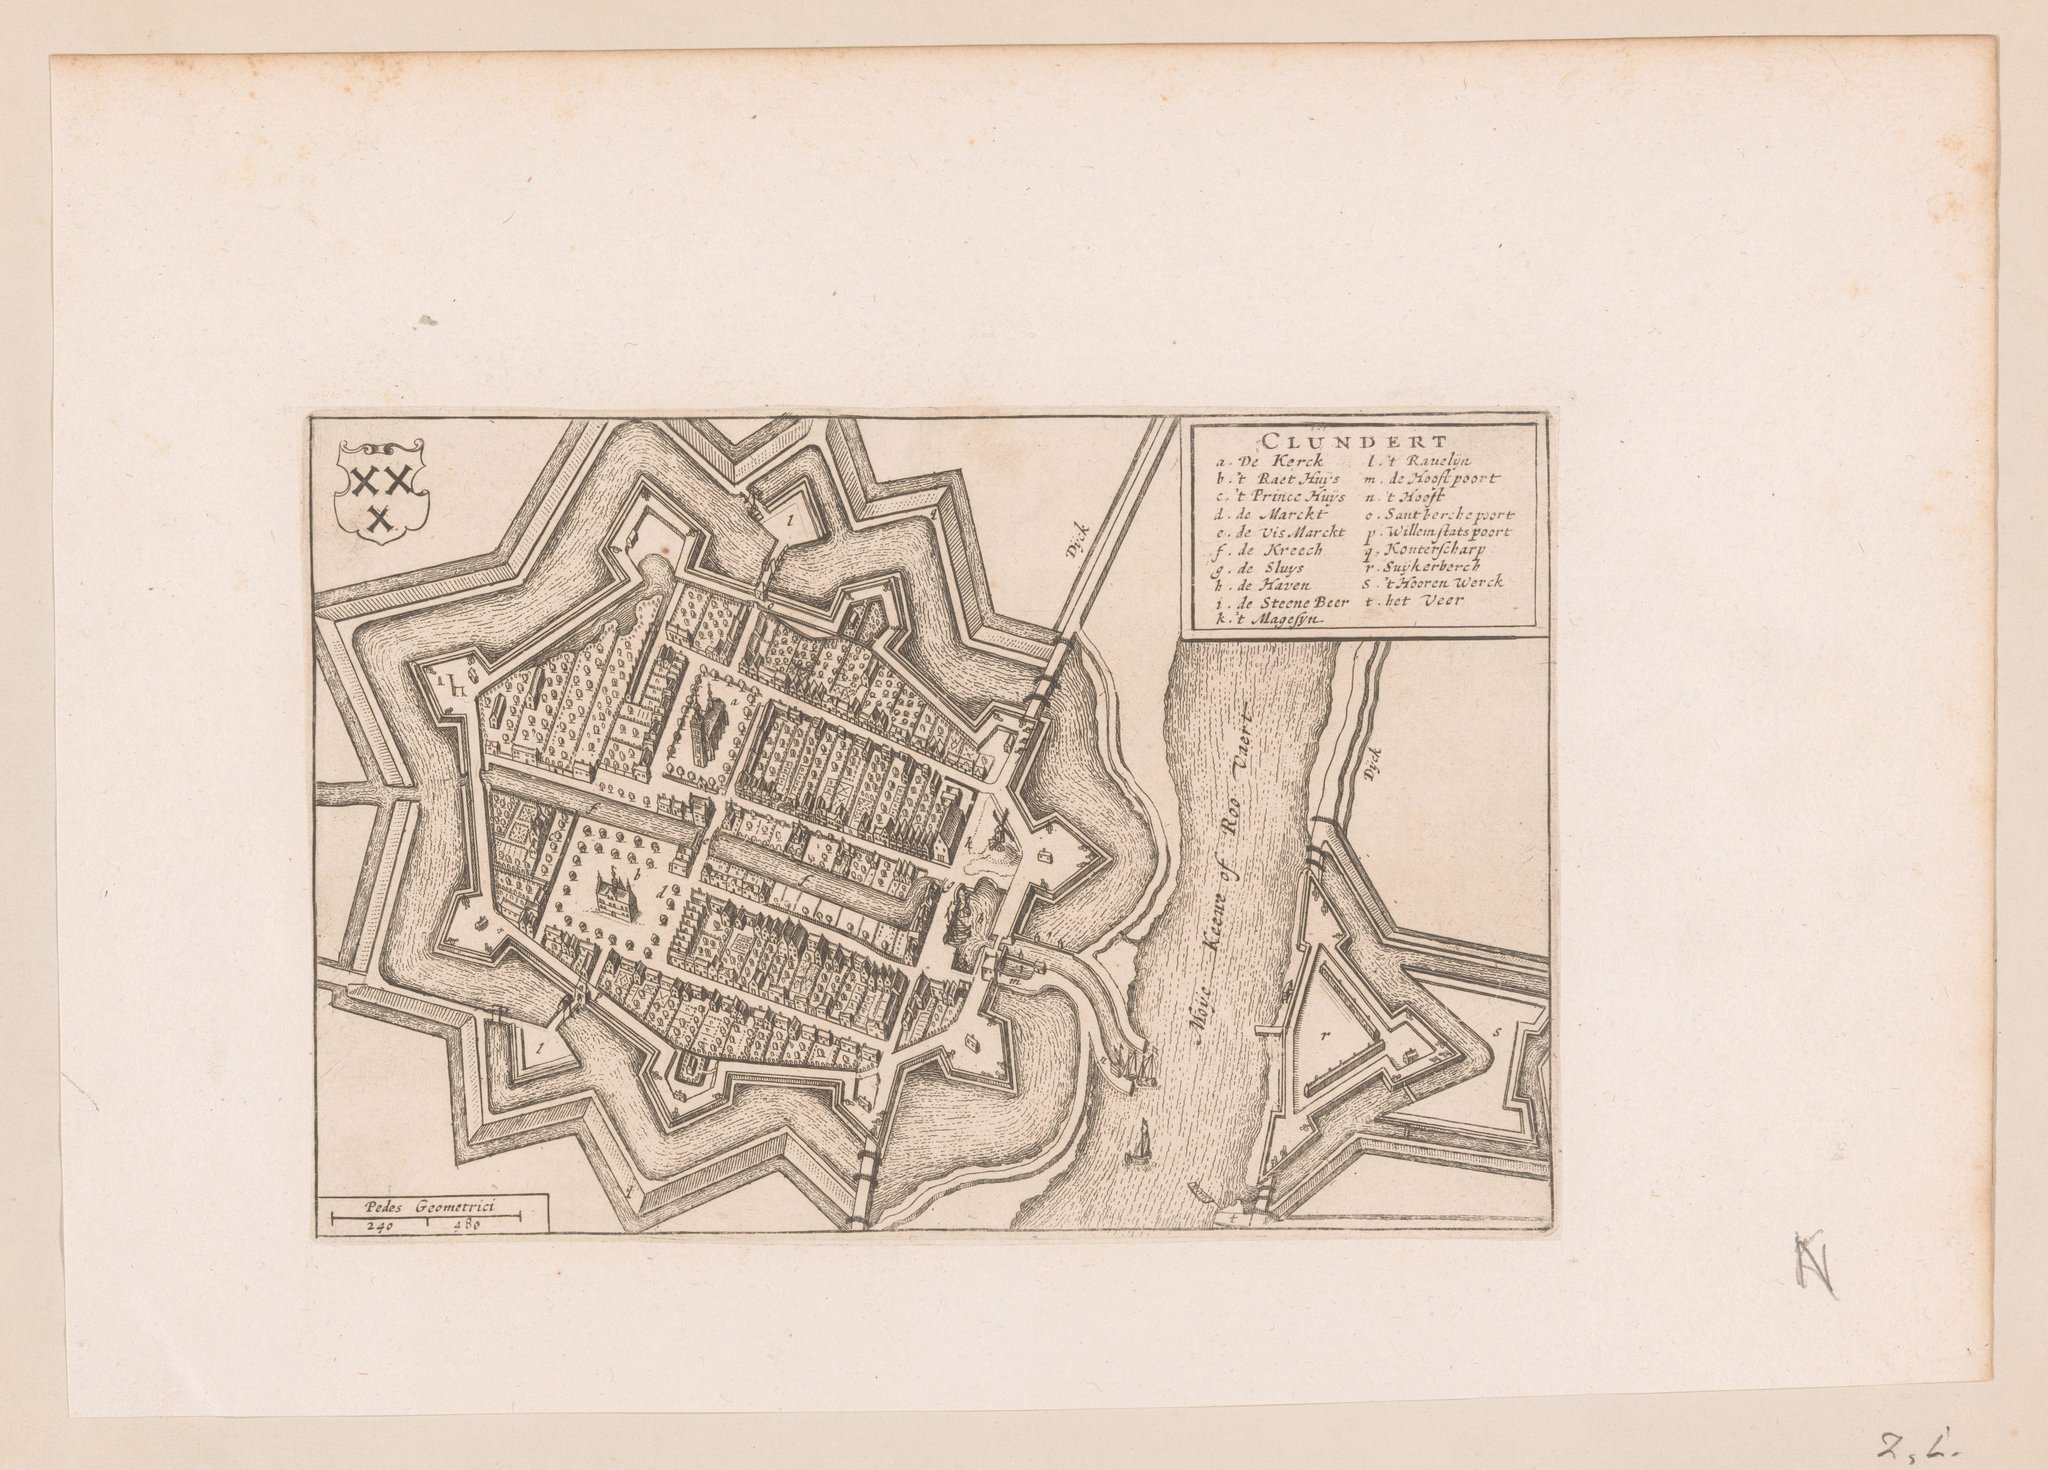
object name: area plan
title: Plattegrond van Klundert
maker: Anonymous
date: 1632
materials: paper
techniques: etching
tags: fortified city, maps of cities, klundert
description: Prent uit: Boxhorn, Marcus Zuerii. Theatrum sive Hollandiae comitatus et urbium nova descriptio (...). Amsterdam: Henricus Hondius, 1632. Daarna is deze plattegrond gebruikt in een aantal edities van Joan Blaeu's 'Toonneel der steden van de Vereenighde Nederlanden', 1649-1652. Zie Koeman, 2010 voor details.